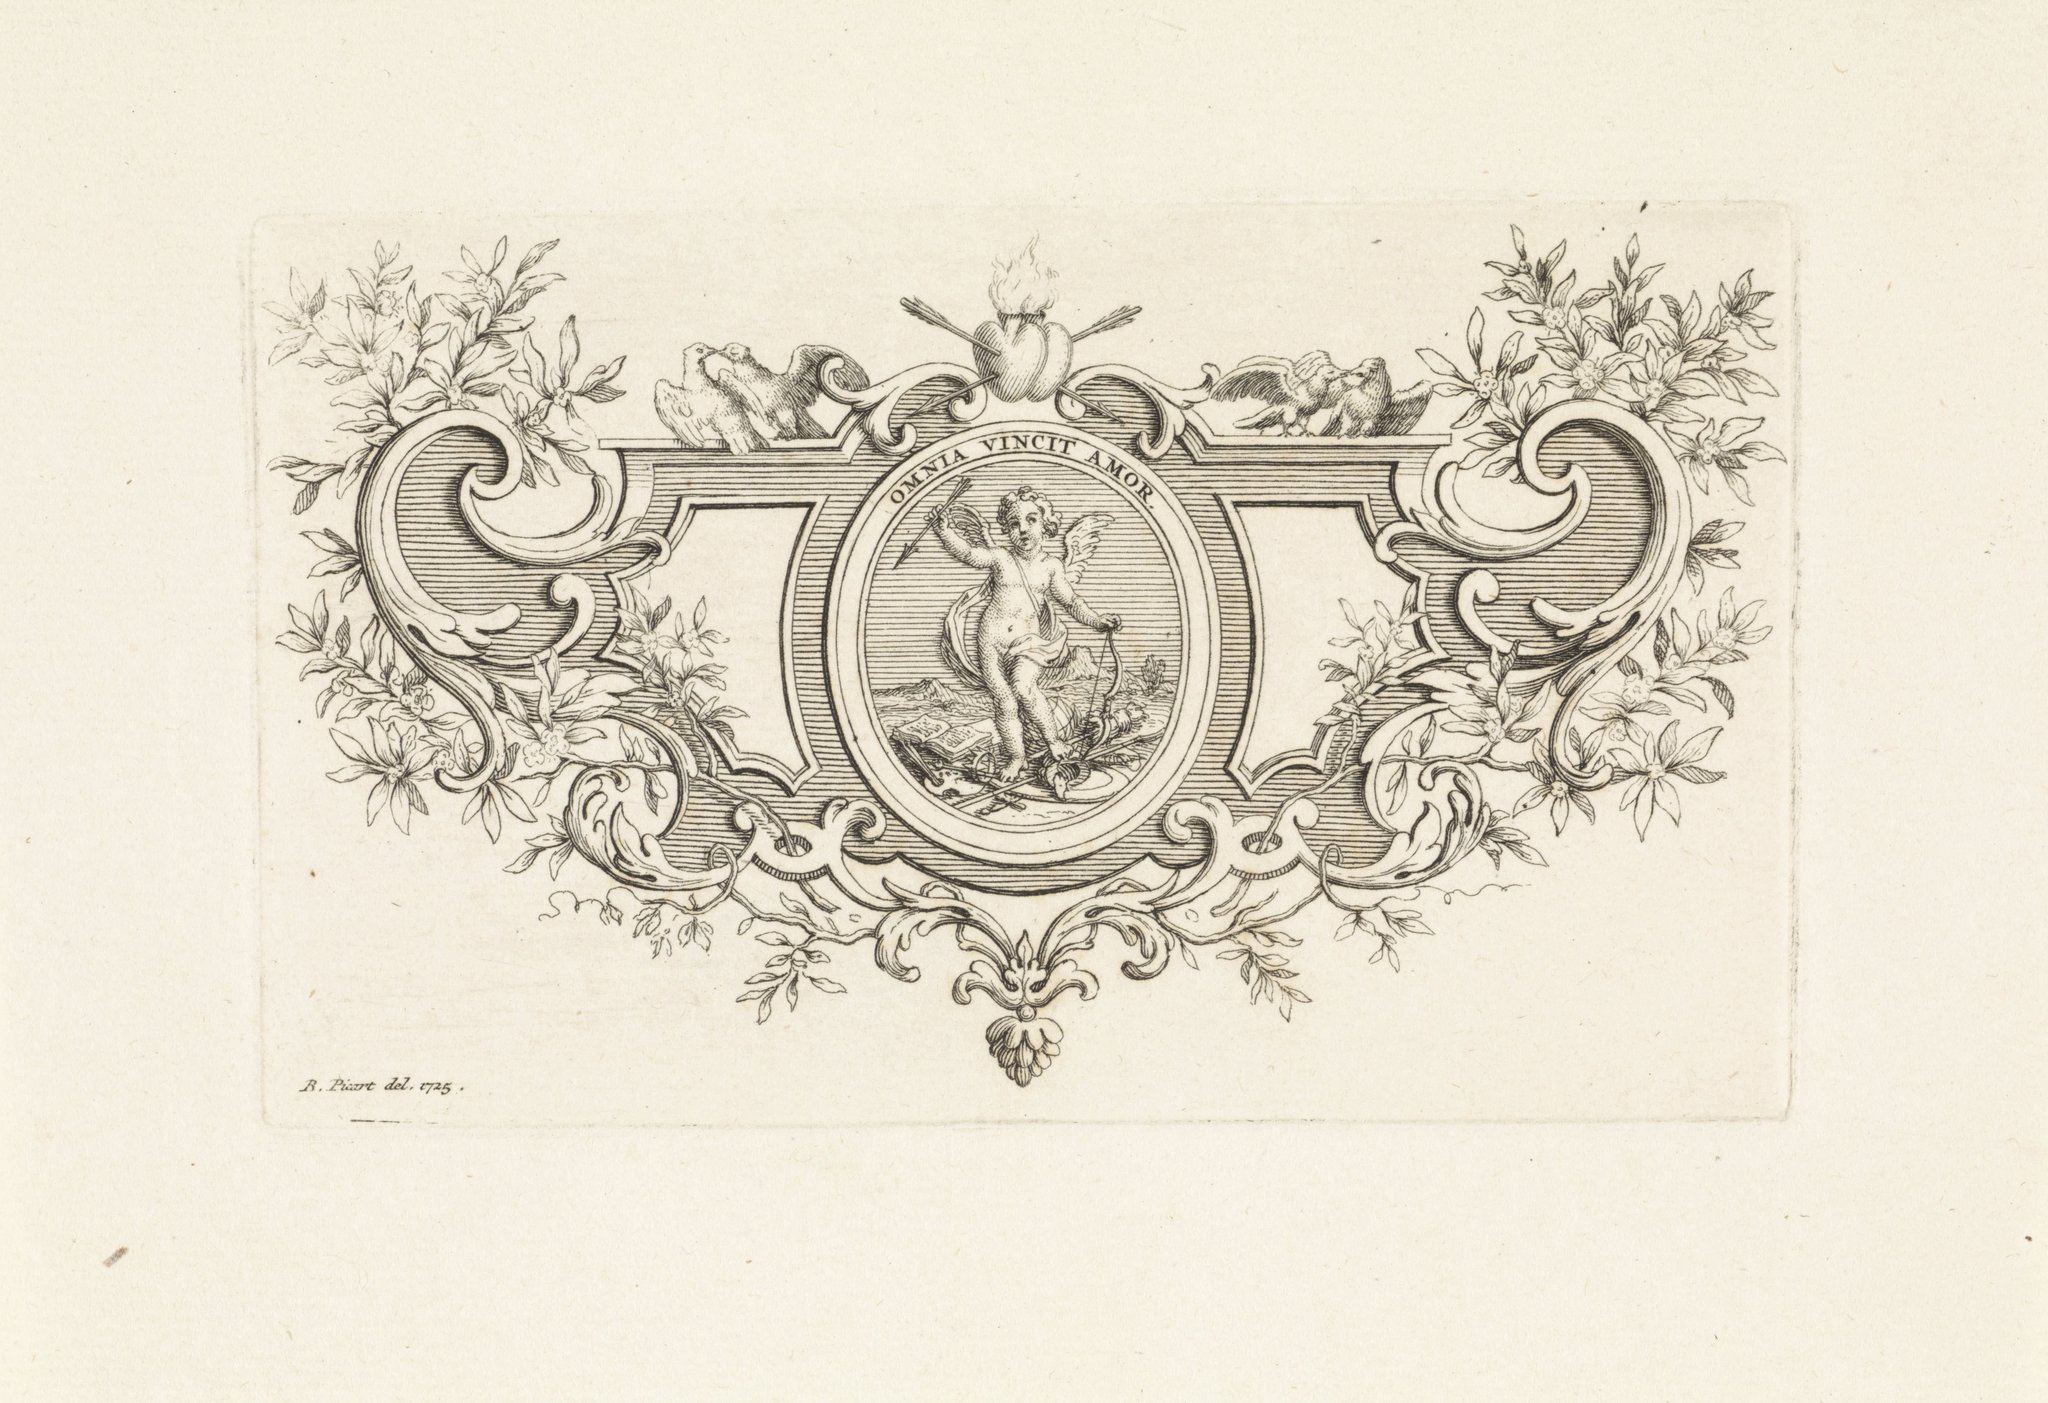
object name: ornament print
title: Triomferende Amor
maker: bernard picart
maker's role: draughtsman, print maker, publisher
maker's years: 1673-1733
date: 1725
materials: paper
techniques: engraving, etching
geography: amsterdam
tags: ornaments ~ art, 'omnia vincit amor', love the conqueror, love triumphant, foliage, tendrils, branches ~ ornament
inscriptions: collector's mark: Lugt 2228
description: Amor toont in triomf zijn pijl en boog, staande op allerlei aardse zaken als een kroon en een schilderspalet. Boven het medaillon het devies: Omnia vincit Amor (Liefde overwint alles). De voorstelling wordt bekroond door twee brandende harten. Rond de voorstelling ornament van bladranken.